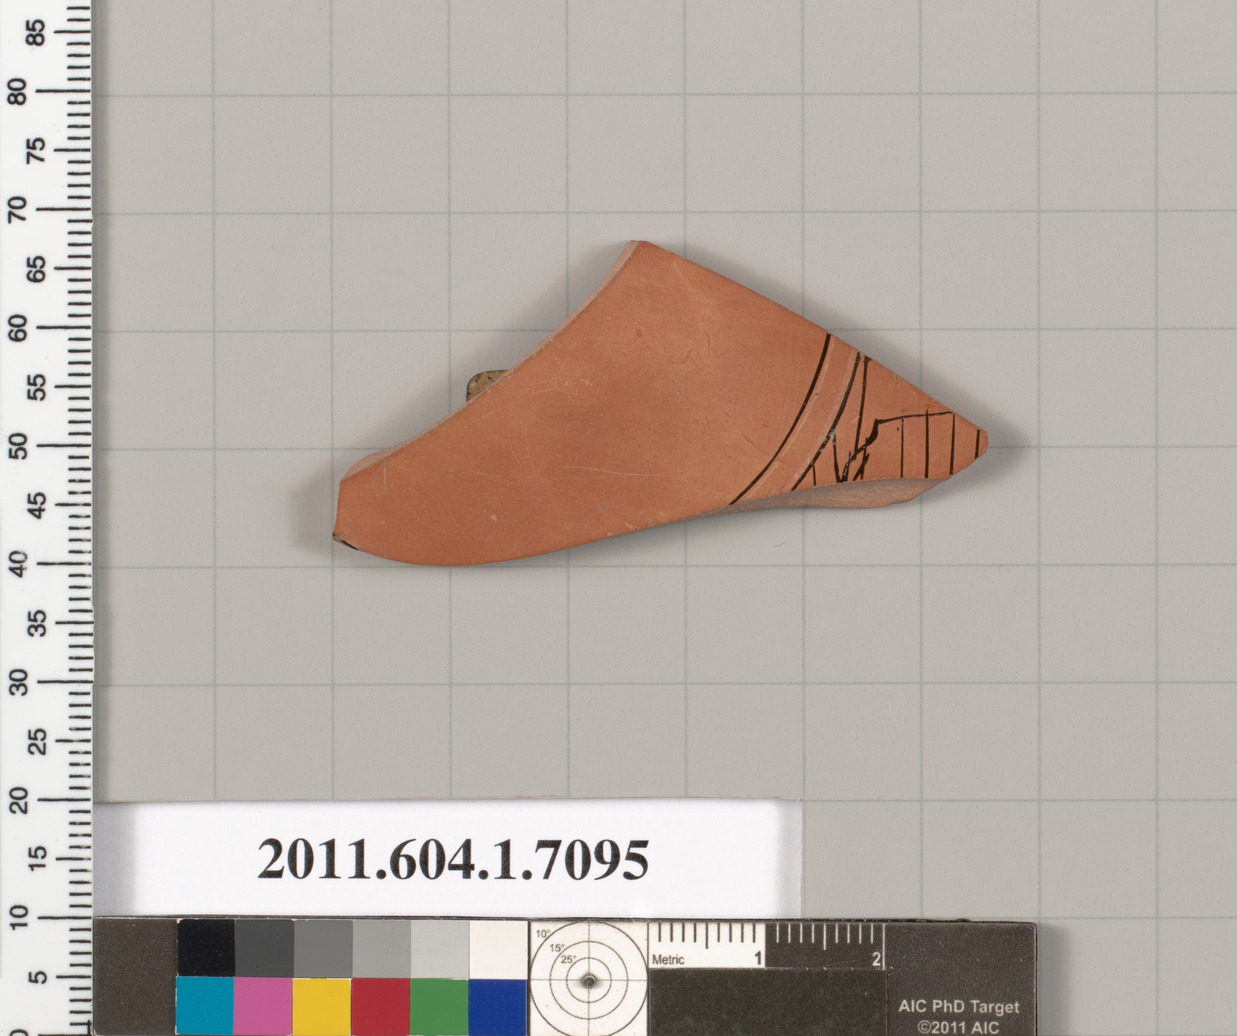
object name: kylix fragment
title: Terracotta fragment of a kylix (drinking cup)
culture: greek, attic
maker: douris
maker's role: artist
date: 500-480 BCE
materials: terracotta